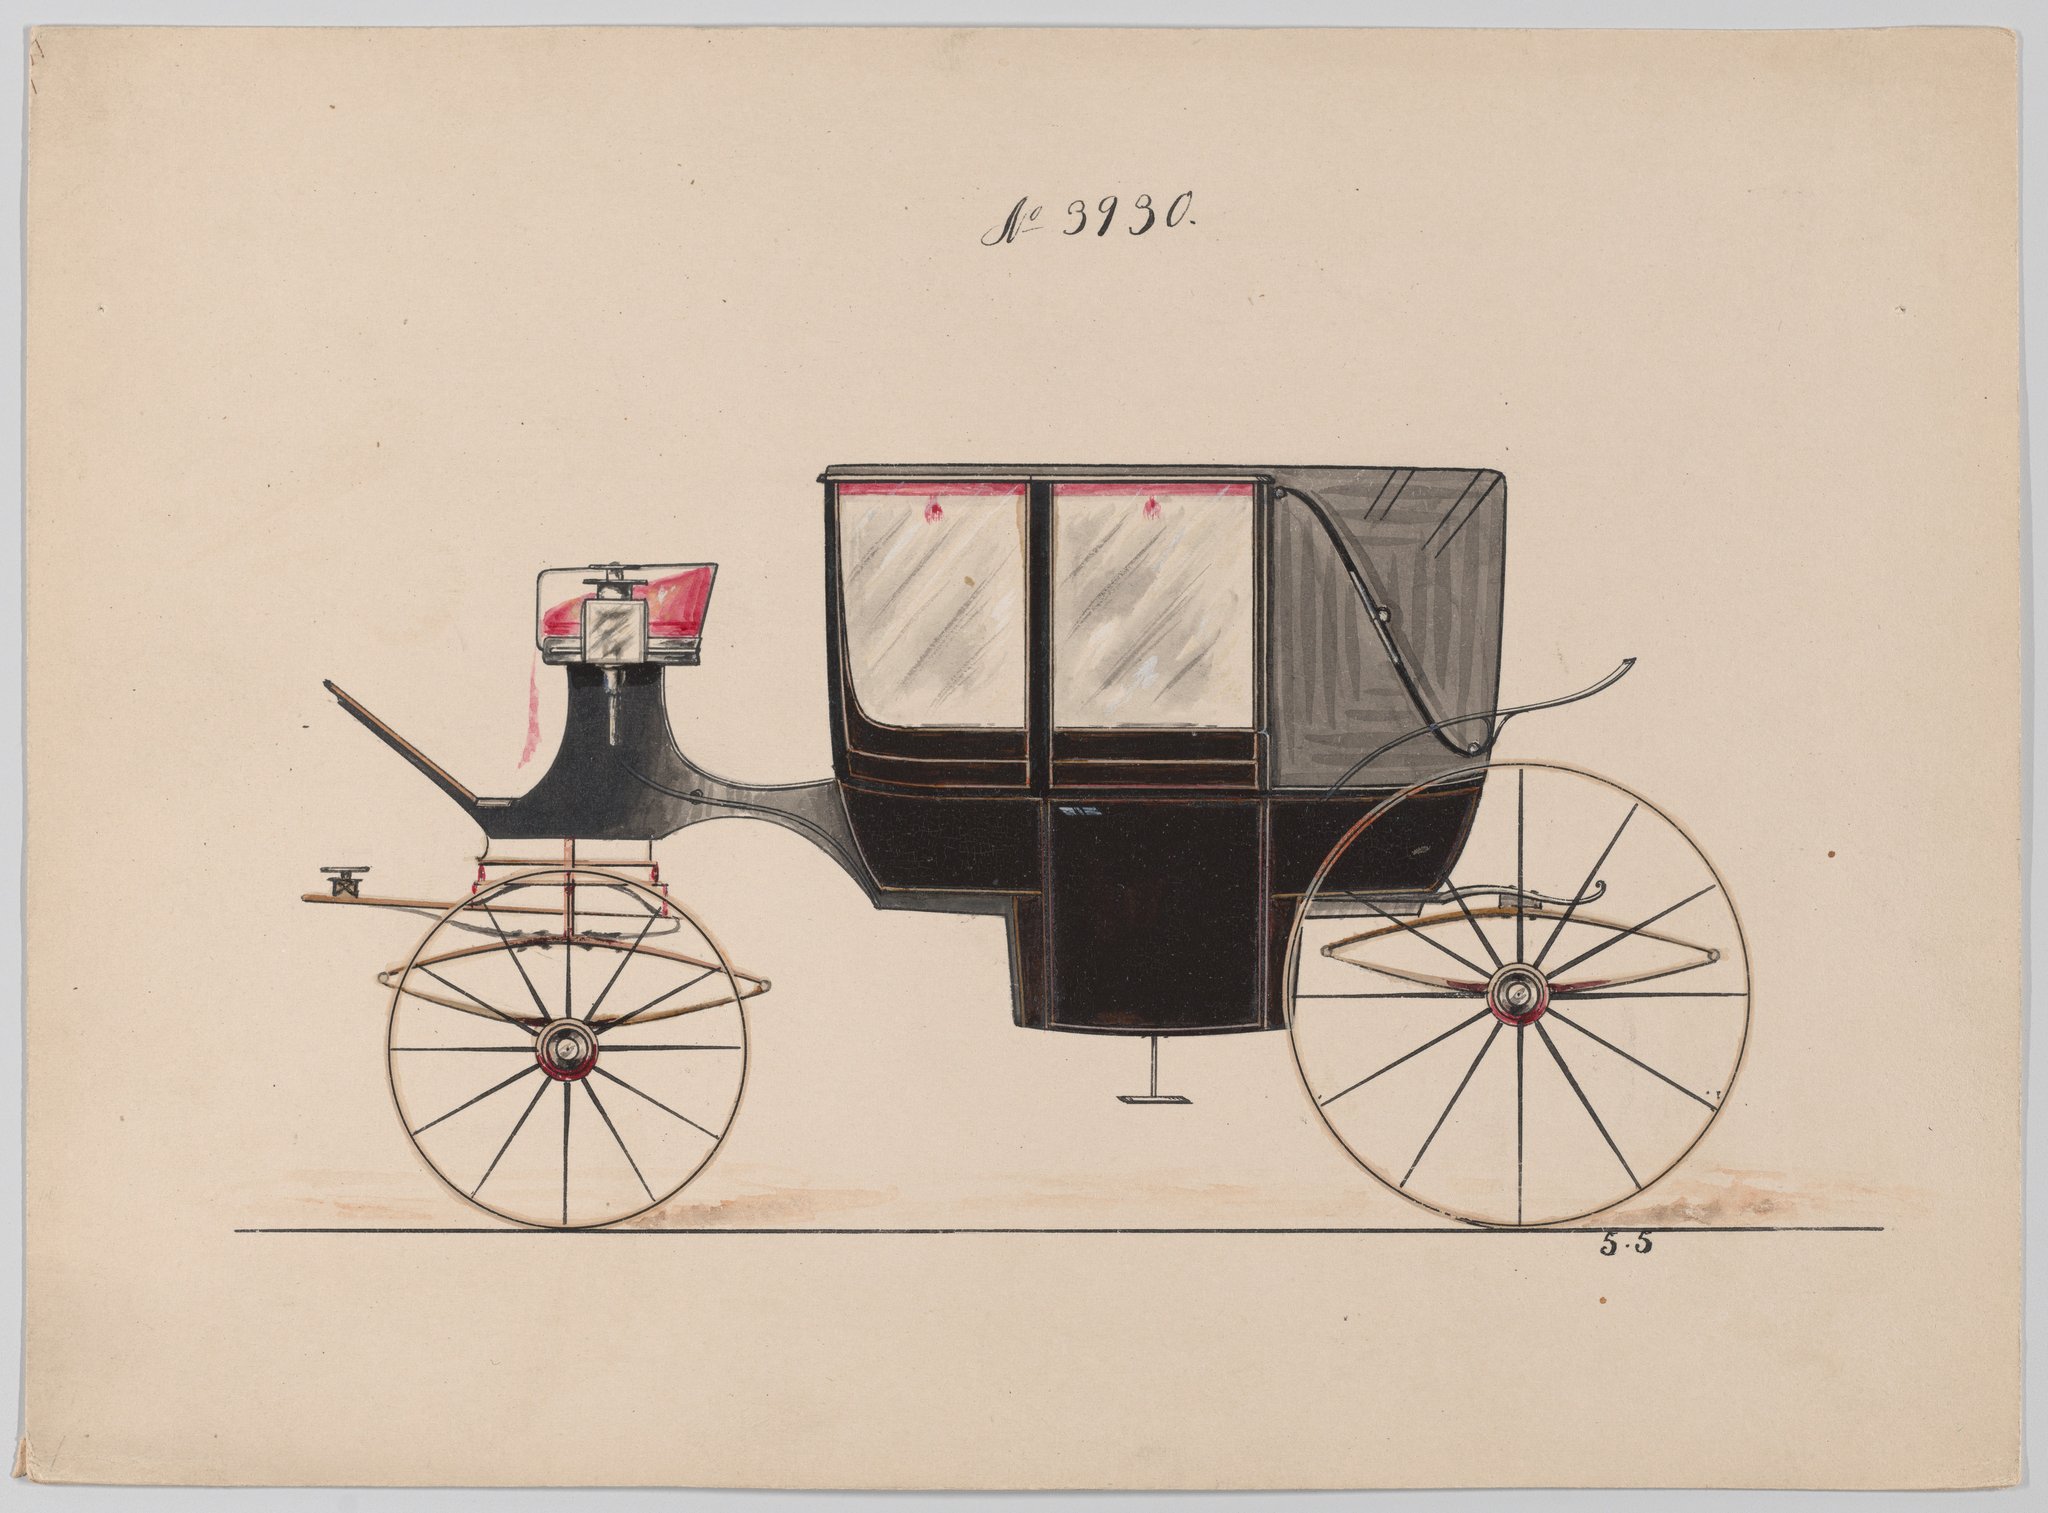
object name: drawing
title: Design for Landau, No. 3930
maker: brewster & co.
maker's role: manufacturer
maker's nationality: american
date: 1884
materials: gum arabic, ink, watercolor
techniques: pen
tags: carriages